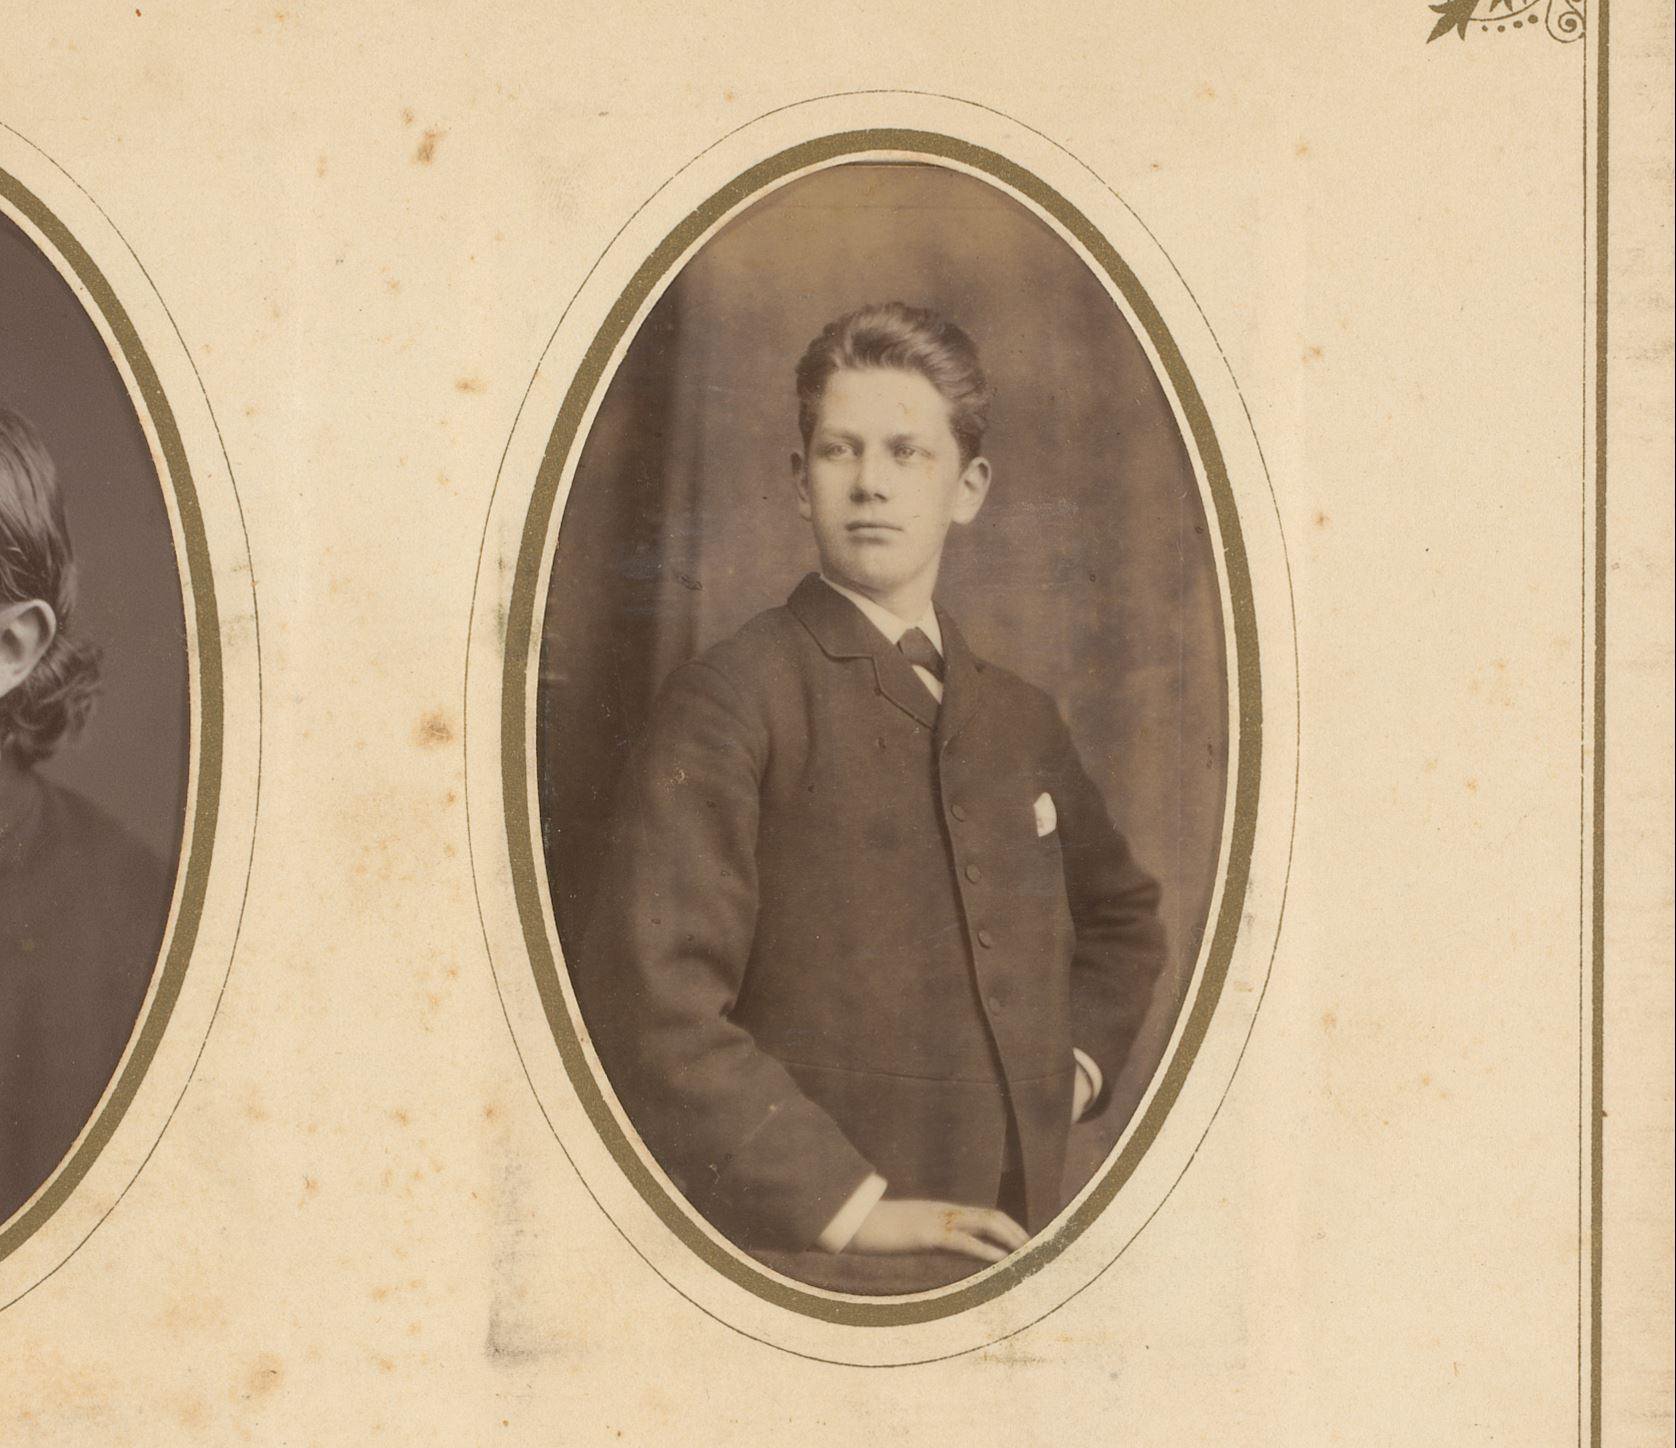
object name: photograph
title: Portret van een staande jonge man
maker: j.j.d. van geuns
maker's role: fotograaf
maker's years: 1852-1885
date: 1882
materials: cardboard, celluloid, photographic support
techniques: albumen print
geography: appingedam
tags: standing figure, historical persons, youth, adolescent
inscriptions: inscription: ‘Photographie/ van/ J.J.D. van Geuns/ Appingedam/ Inrichting voor vergrootingen./ Het cliché blijft voor nabestellingen bewaart.’